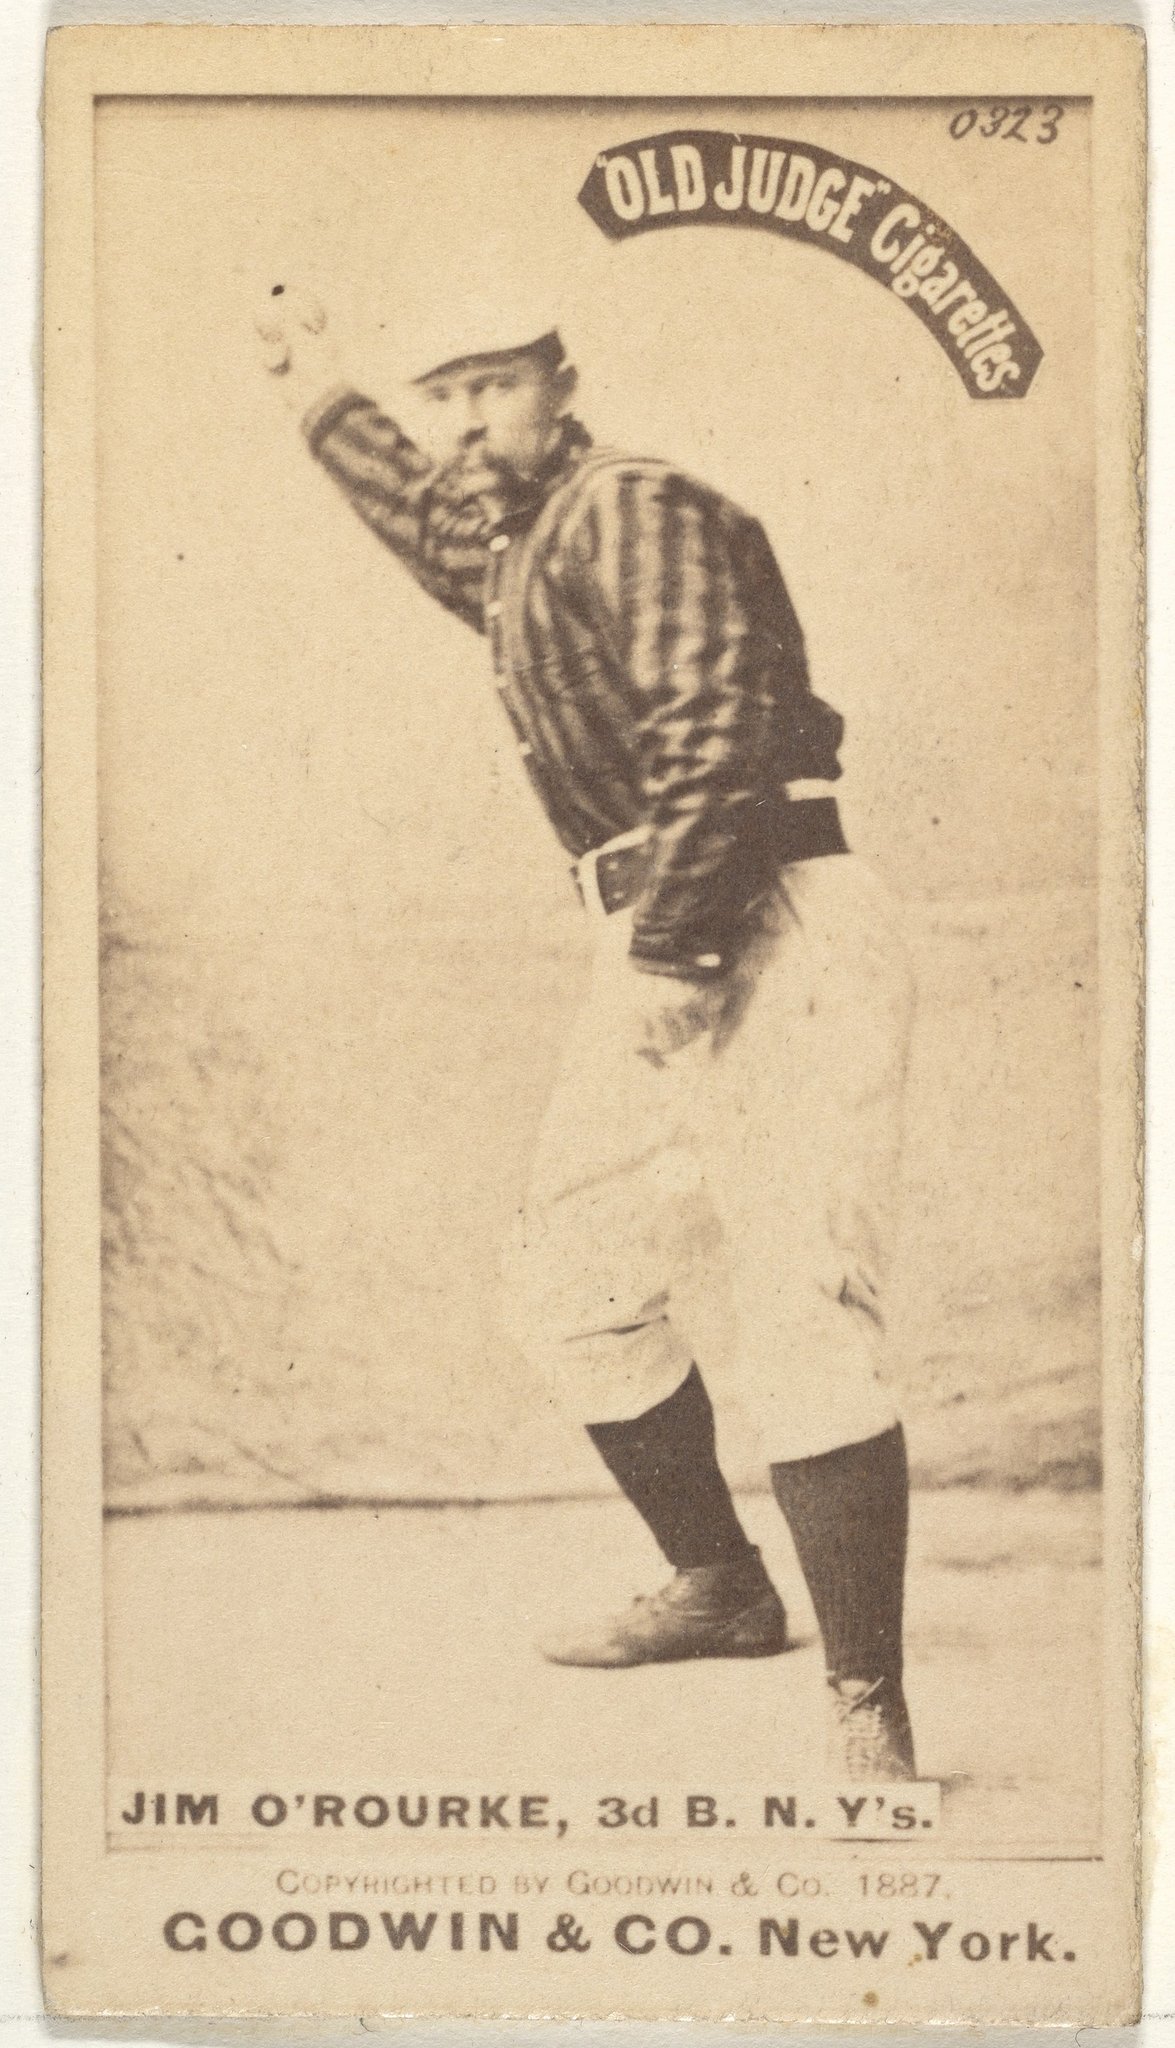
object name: baseball card, photograph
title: James Henry O'Rourke, 3rd Base, New York, from the Old Judge series (N172) for Old Judge Cigarettes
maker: goodwin & company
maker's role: publisher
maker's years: 1850-1950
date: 1887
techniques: albumen silver print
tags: men,portraits,baseball,athletes